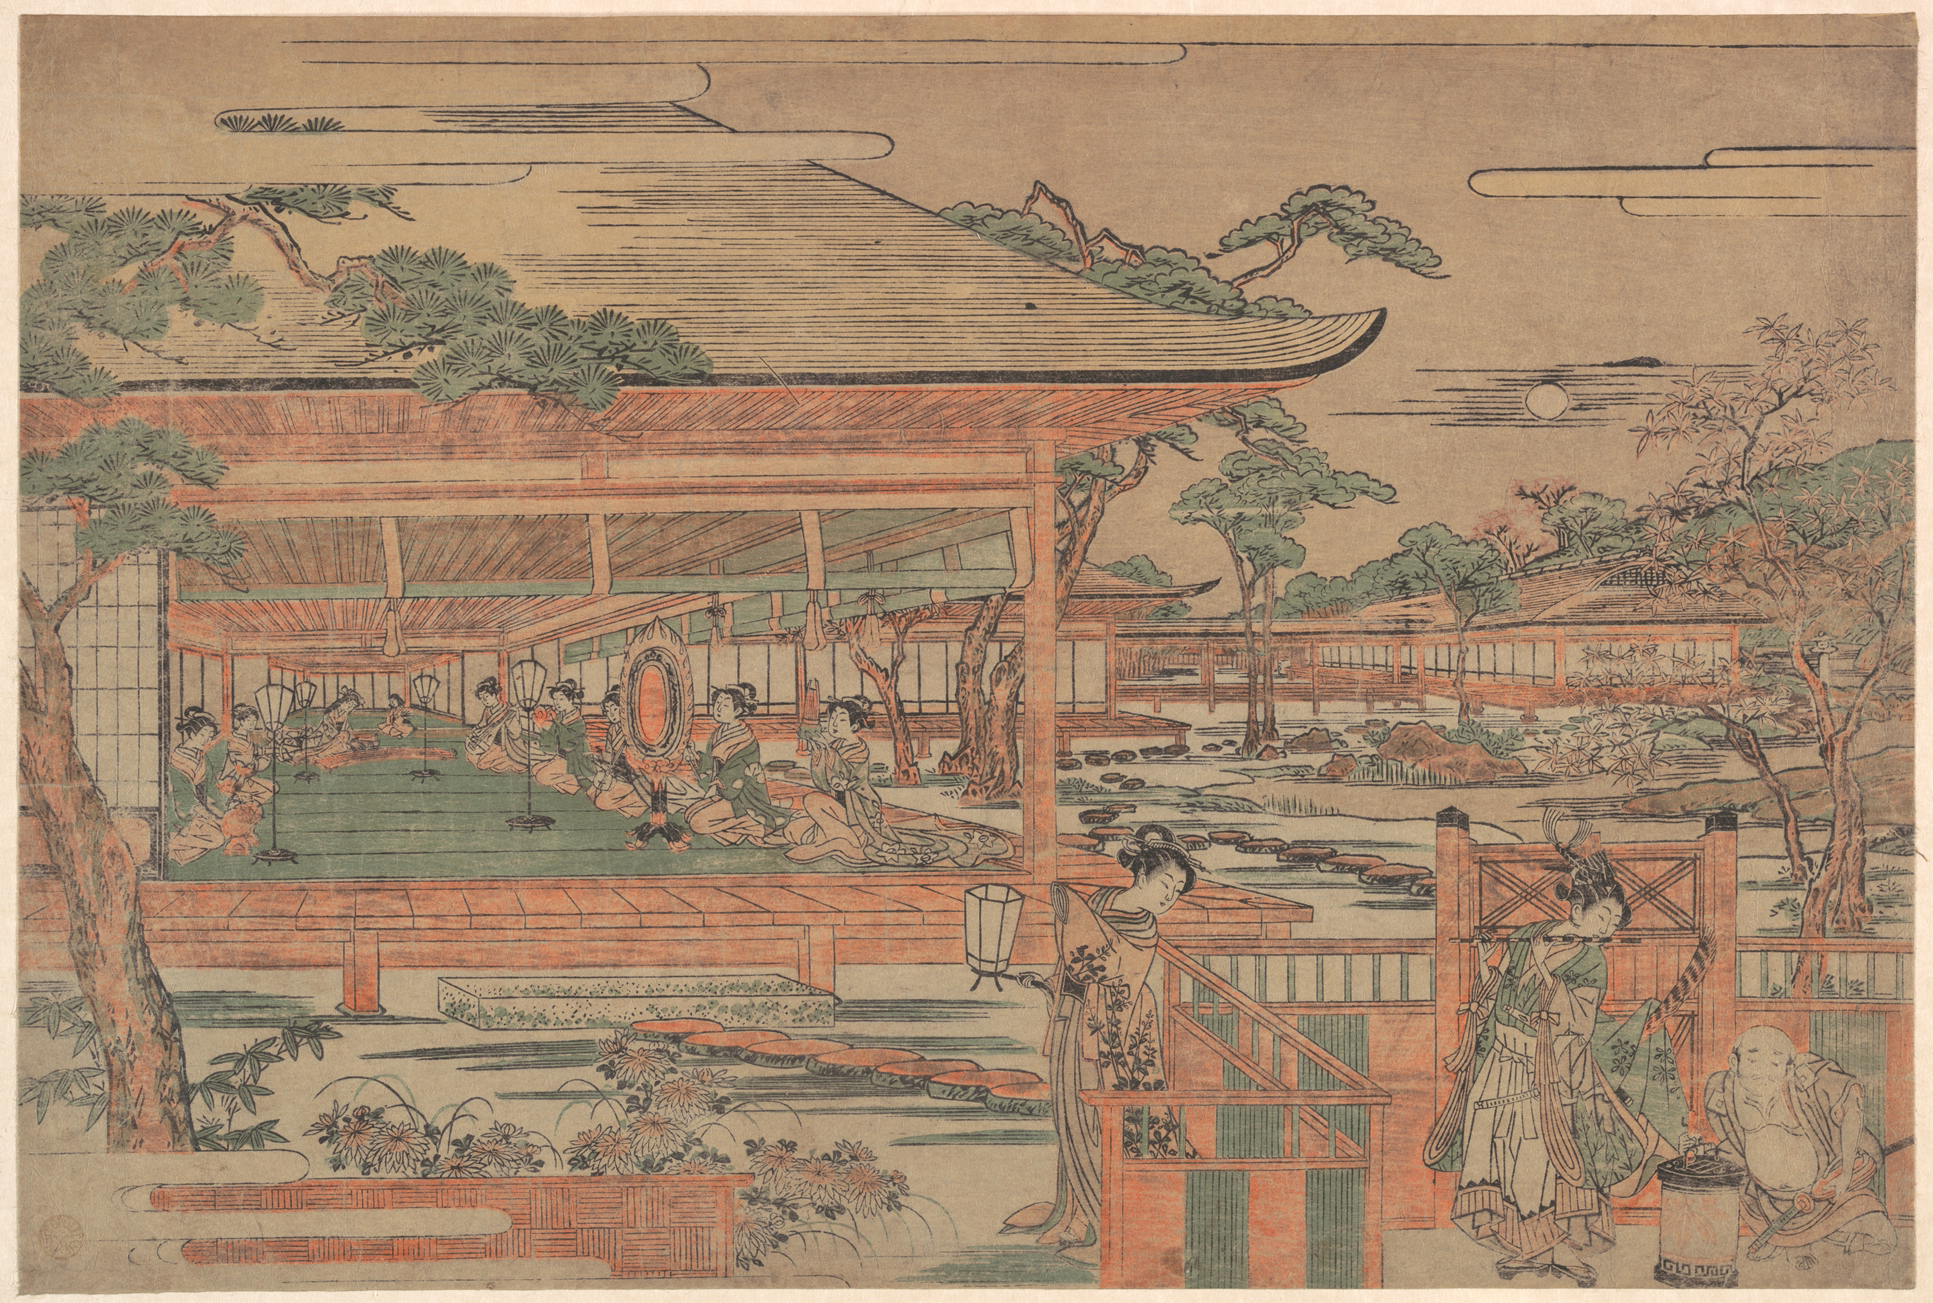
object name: print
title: Ushiwaka, the Young Yoshitsune Serenading Jorurihime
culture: japanese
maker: kitao shigemasa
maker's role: artist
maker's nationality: japanese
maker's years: 1739-1820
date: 1772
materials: ink, paper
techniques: woodblock print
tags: houses,men,women,trees